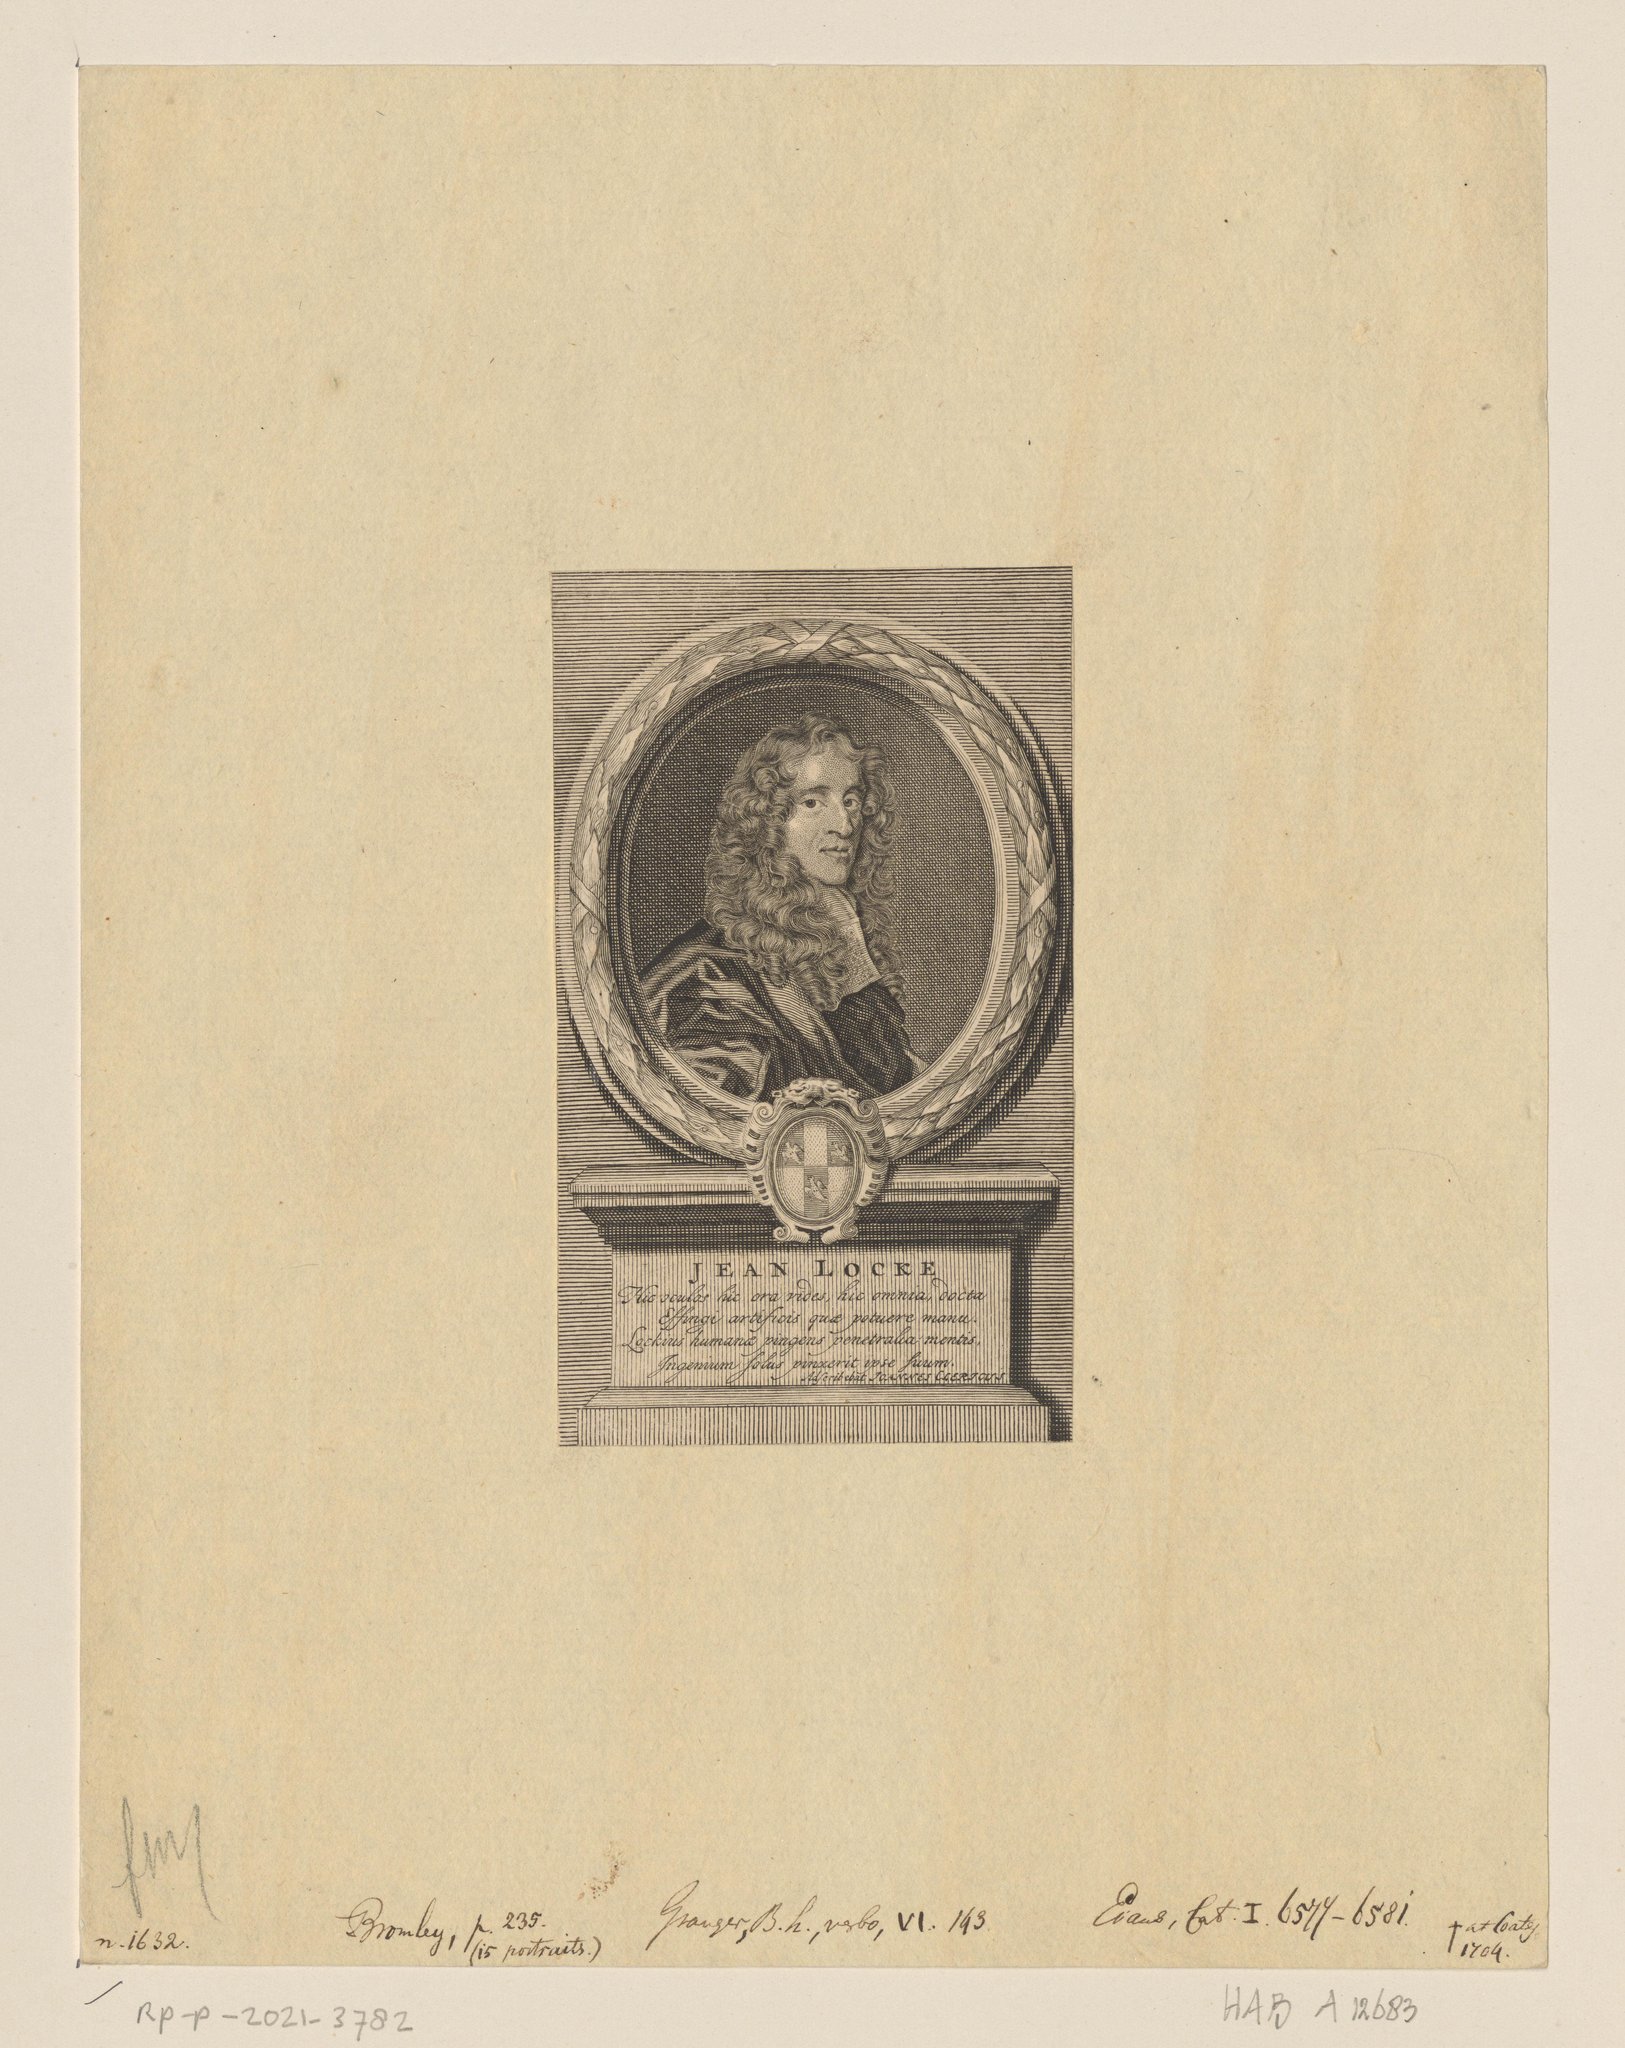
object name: book illustration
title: Portret van John Locke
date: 1715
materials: paper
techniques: engraving, etching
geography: northern netherlands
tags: physicist, ornament ~ medallion, historical persons, scholar, philosopher (+ portrait of scholar, scientist), armorial bearing, heraldry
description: Prent waarschijnlijk uit: Locke, John. Le Christianisme Raisonnable (...). 2 dln. Amsterdam: L'Honoré et Chatelain, 1715.